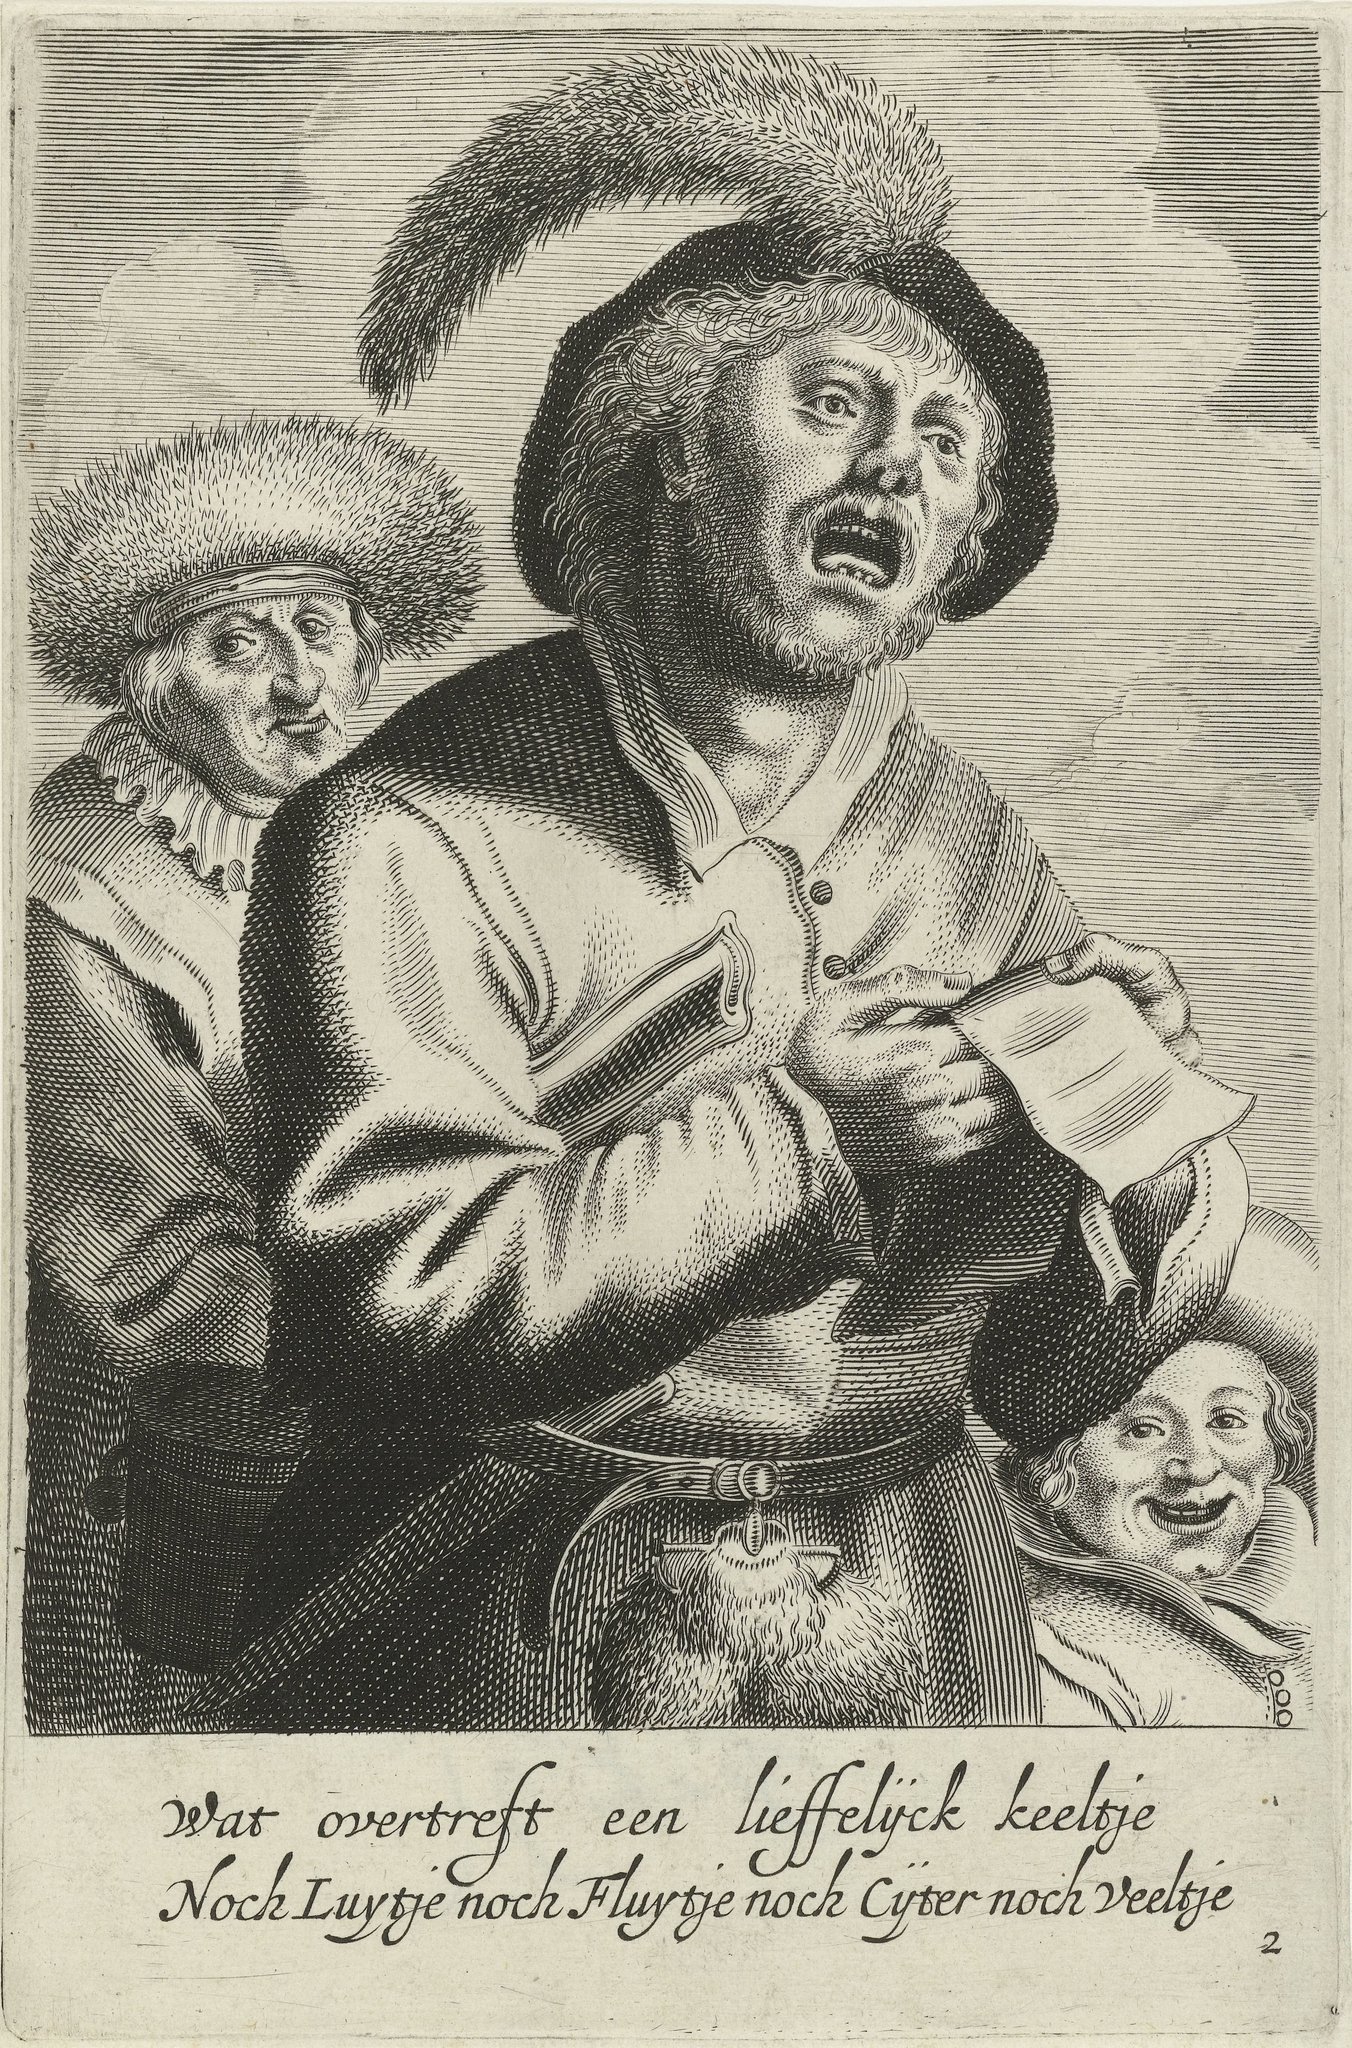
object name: print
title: Street Singer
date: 1603-1652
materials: paper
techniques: engraving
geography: northern netherlands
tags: vocal music, singing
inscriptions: collector's mark: Lugt 240, caption: ‘Wat overtreft een lieflijck keeltje / Noch Luytje noch Fluytje noch Cijter noch veeltje’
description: In the 17th century, people in the Netherlands liked to sing in their own language. To this end, countless collections of songs and loose-leafed texts were published for nearly every occasion: for a wedding or in a domestic setting, with musical accompaniment but also single-part sing-alongs for the market and pub. The subjects were varied, and usually sung along to an existing tune. Which one it should be was written at the top of the lyrics.